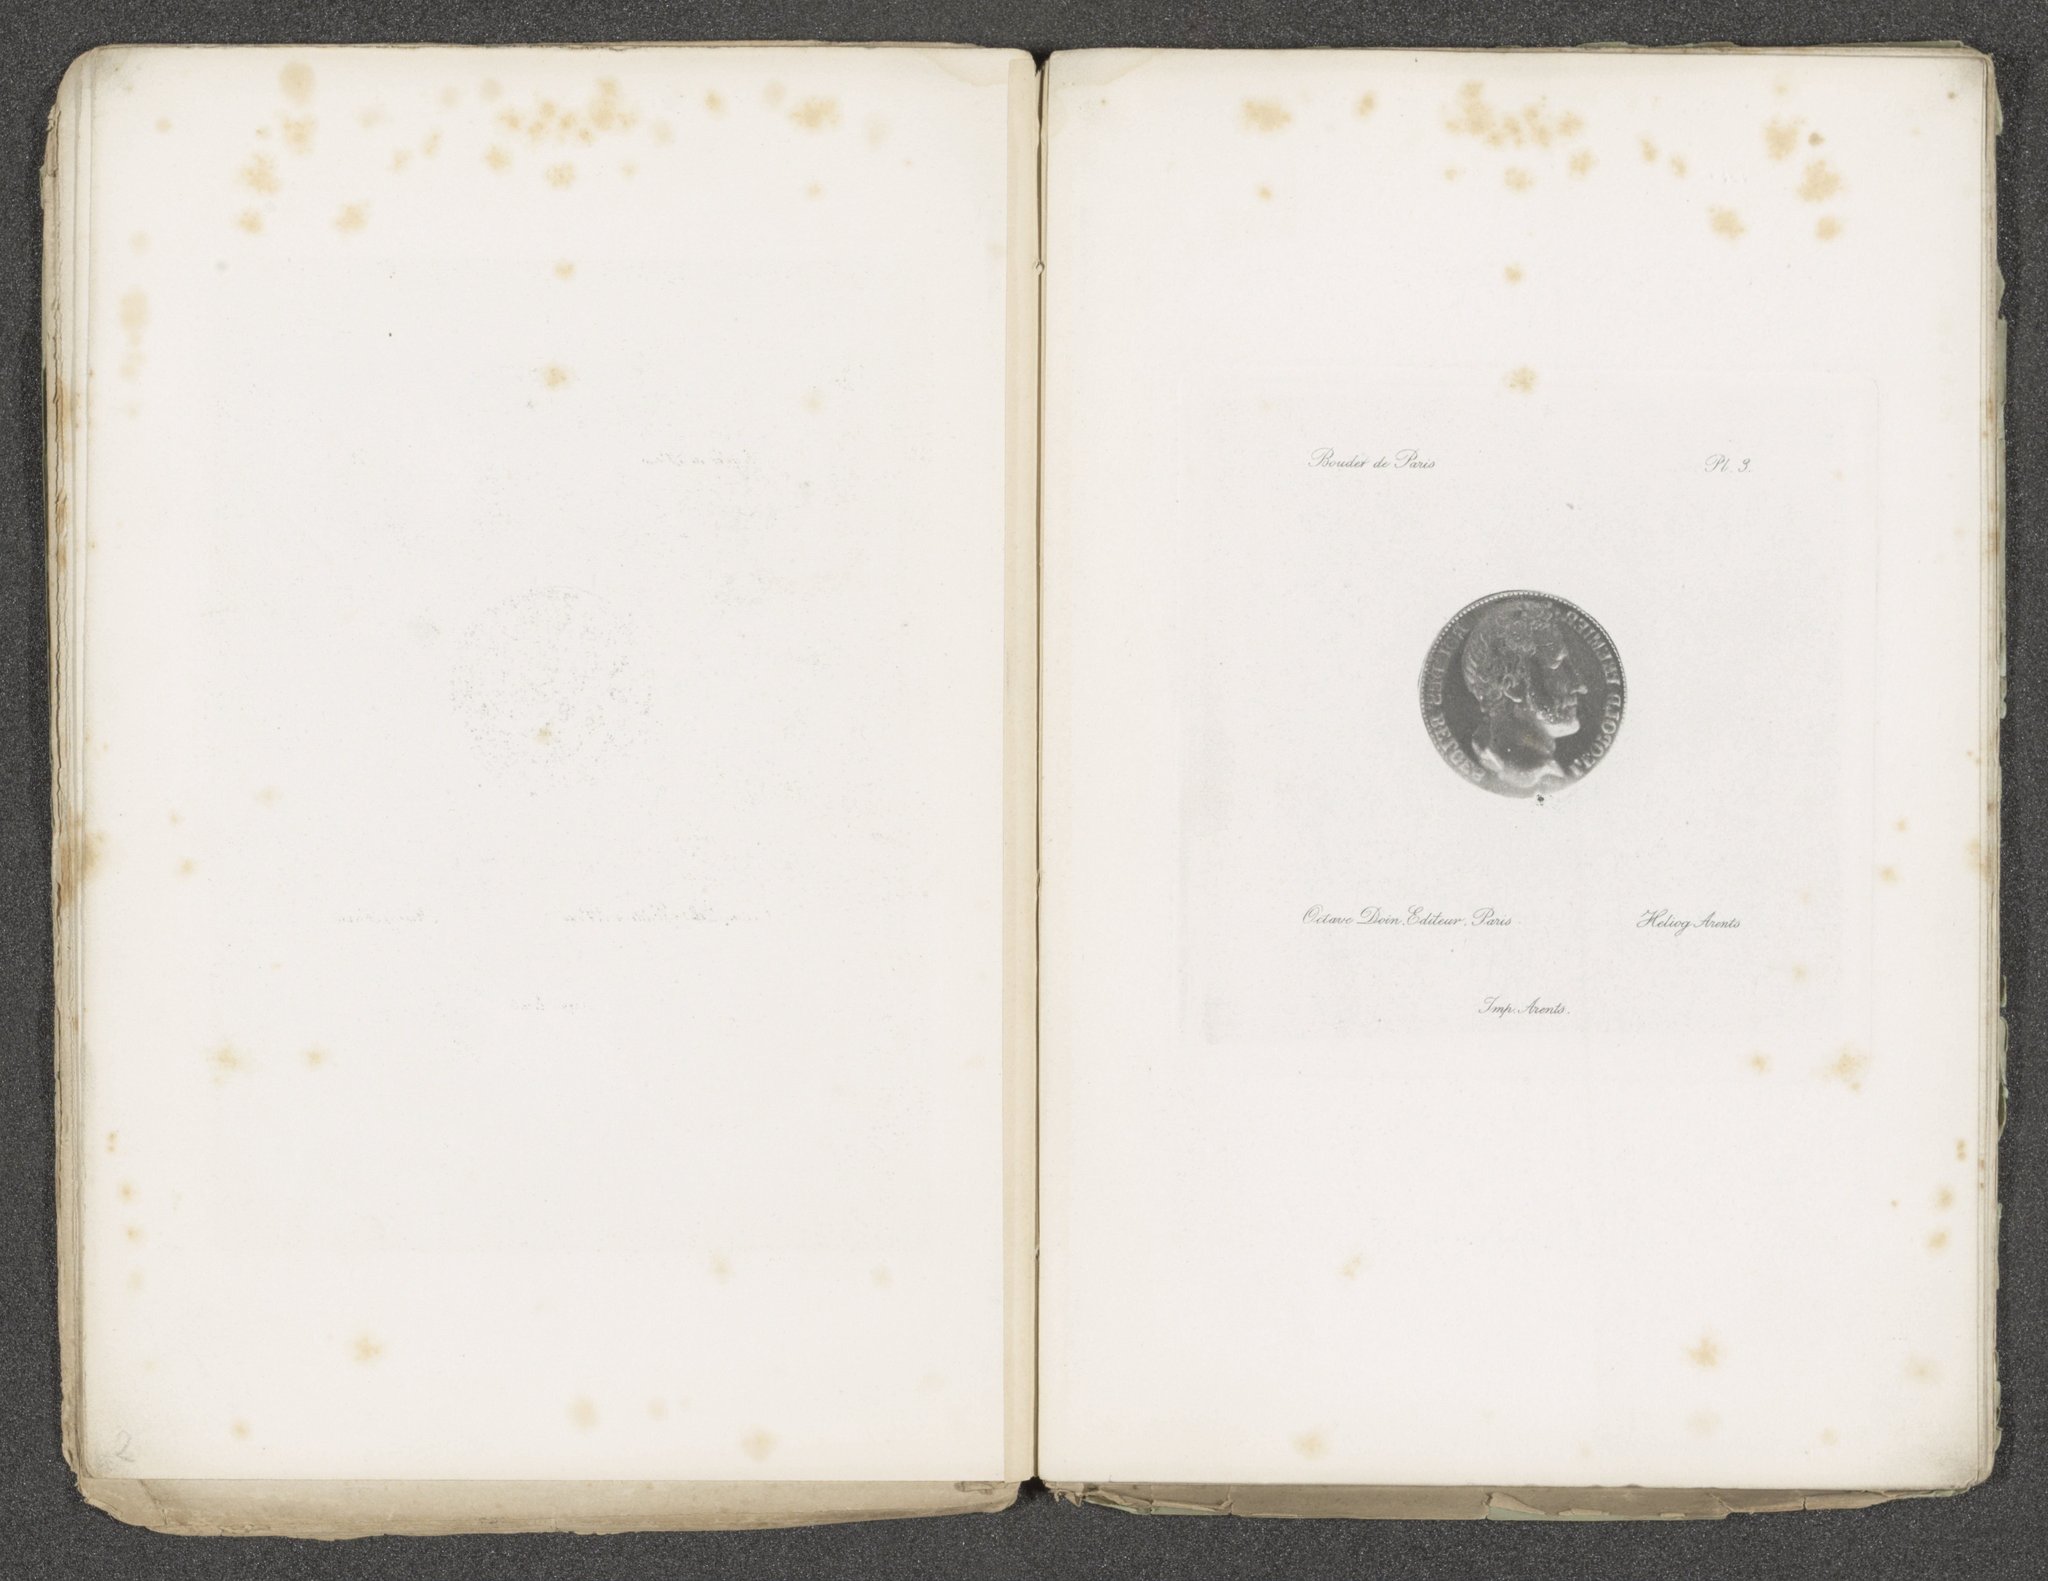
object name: photomechanical print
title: Munt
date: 1876-1886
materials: paper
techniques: photoaquatint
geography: paris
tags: coin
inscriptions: number: ‘Pl. 3.’